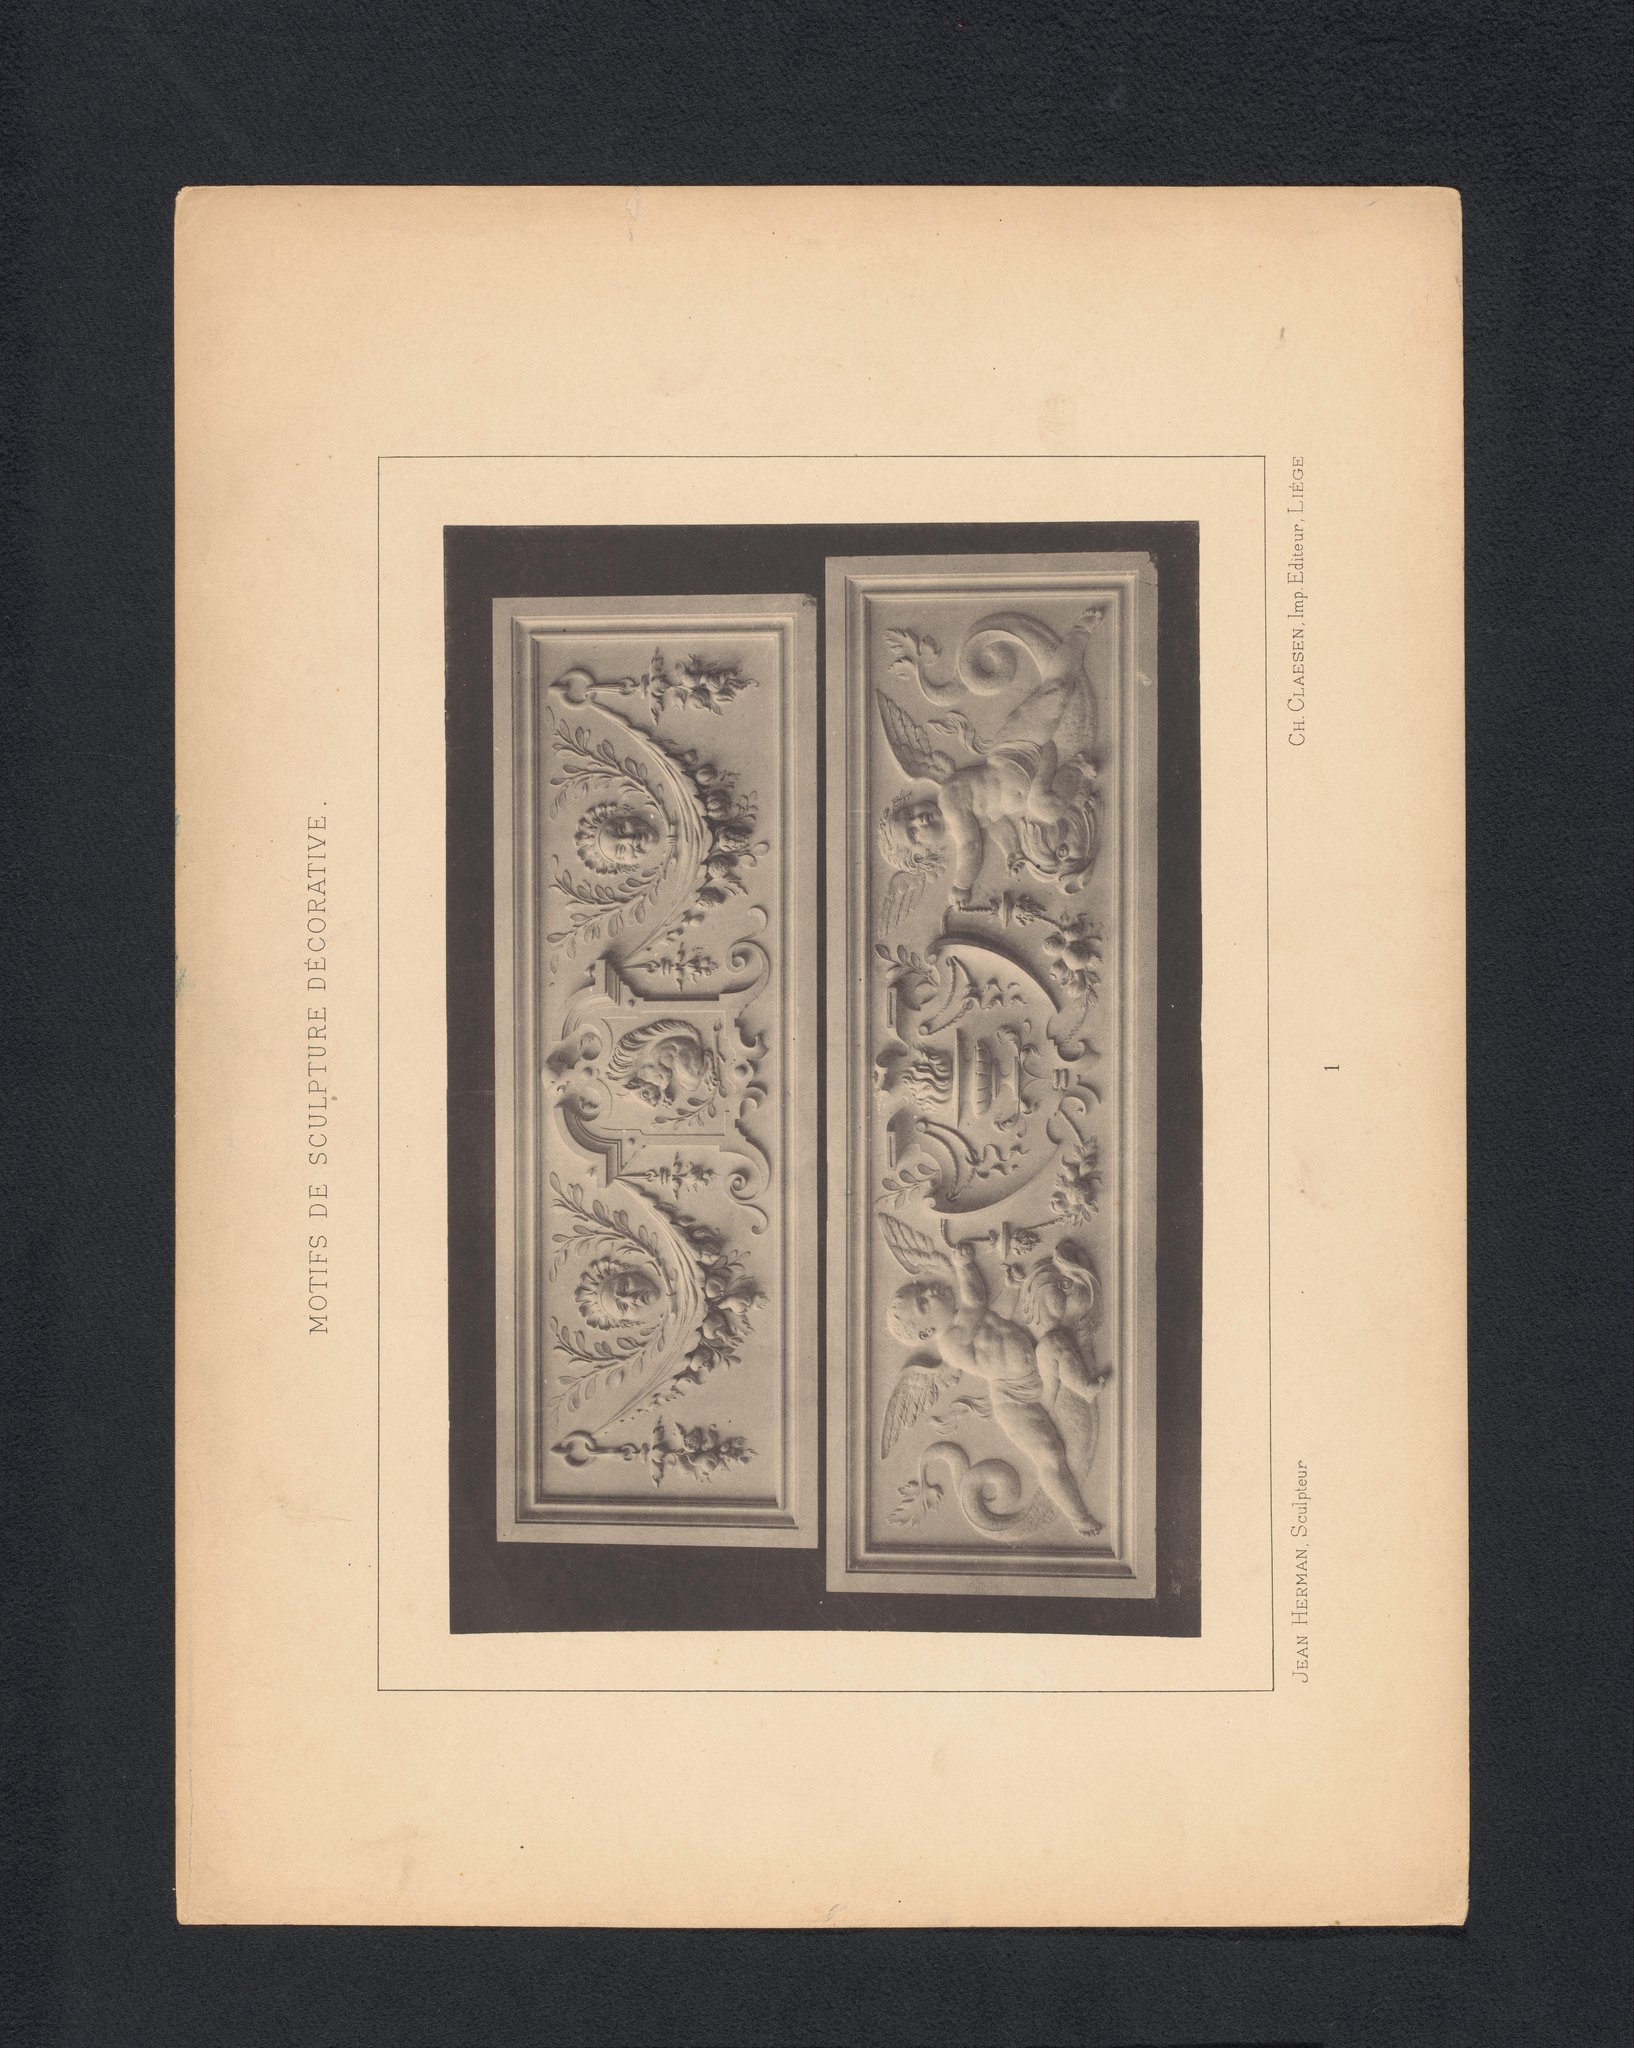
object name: photomechanical print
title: Twee reliëfs met gezichten, bladranken en putti, gebeeldhouwd door Jean Herman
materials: paper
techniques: photograph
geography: liège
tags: cupids: 'amores', 'amoretti', 'putti', ornament derived from plant forms, sculpture (+ relief ~ sculpture)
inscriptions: inscription: ‘Jean Herman, Sculpteur.’, number: ‘1’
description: Deze prent maakt deel uit van een omslag met 28 prenten en een titelblad.